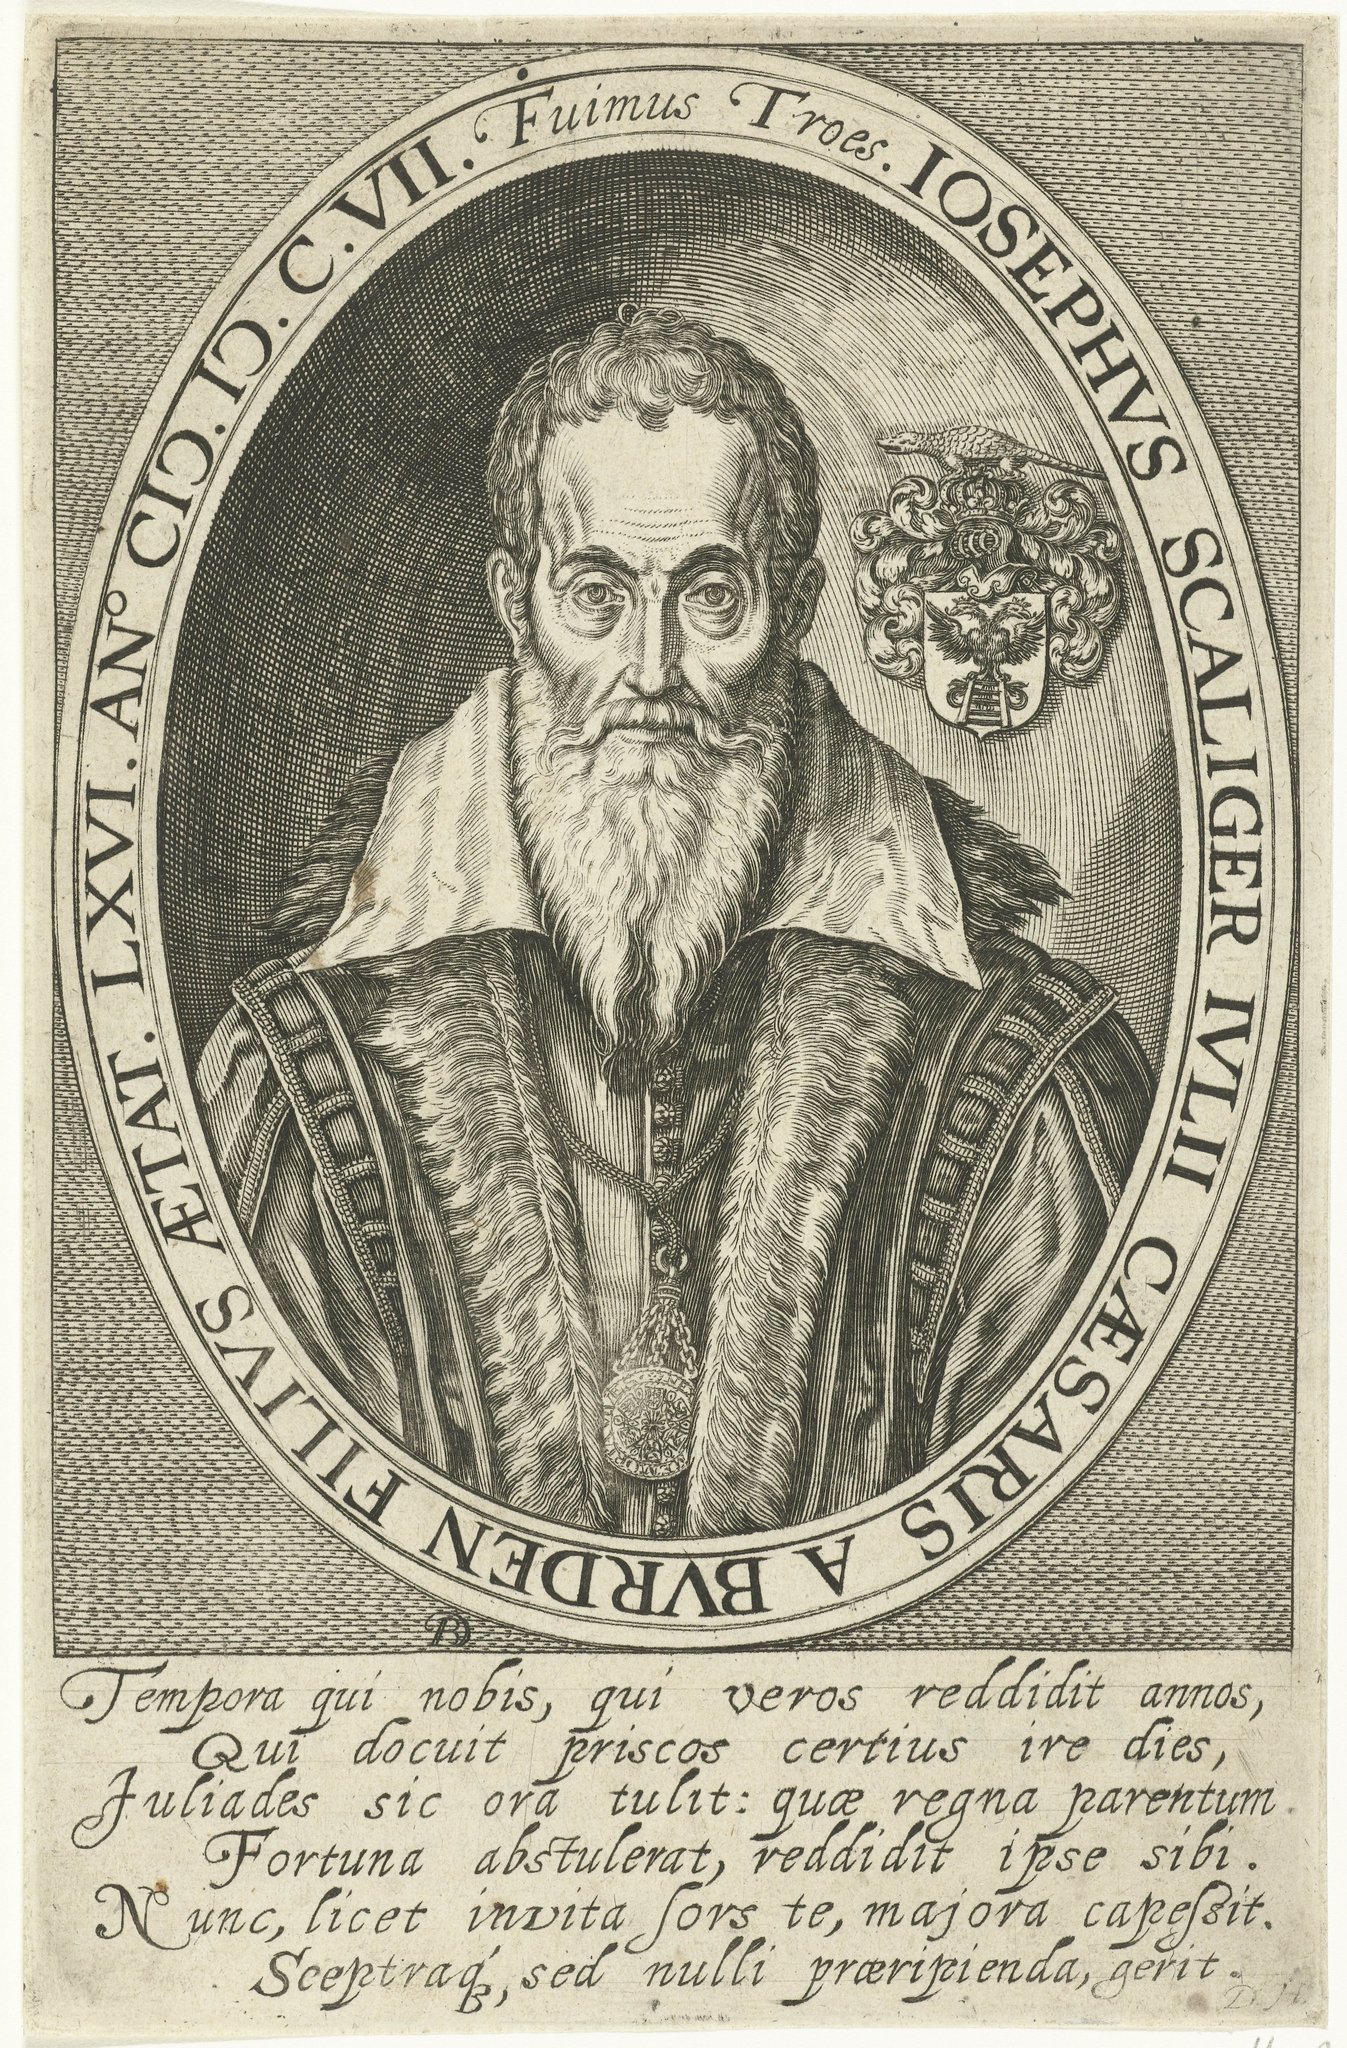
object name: print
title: Portret van Josephus Scaliger op 66-jarige leeftijd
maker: bartholomeus willemsz. dolendo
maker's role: print maker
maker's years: 1560-1626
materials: paper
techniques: engraving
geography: leiden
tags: filoloog, geleerde, josephus scaliger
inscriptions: collector's mark: Lugt 2228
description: Portret van de Leidse geleerde Josephus Scaliger op 66-jarige leeftijd, in ovaal met randschrift. Op de achtergrond zijn wapen. Onder het portret een Latijns vers getekend D.H.